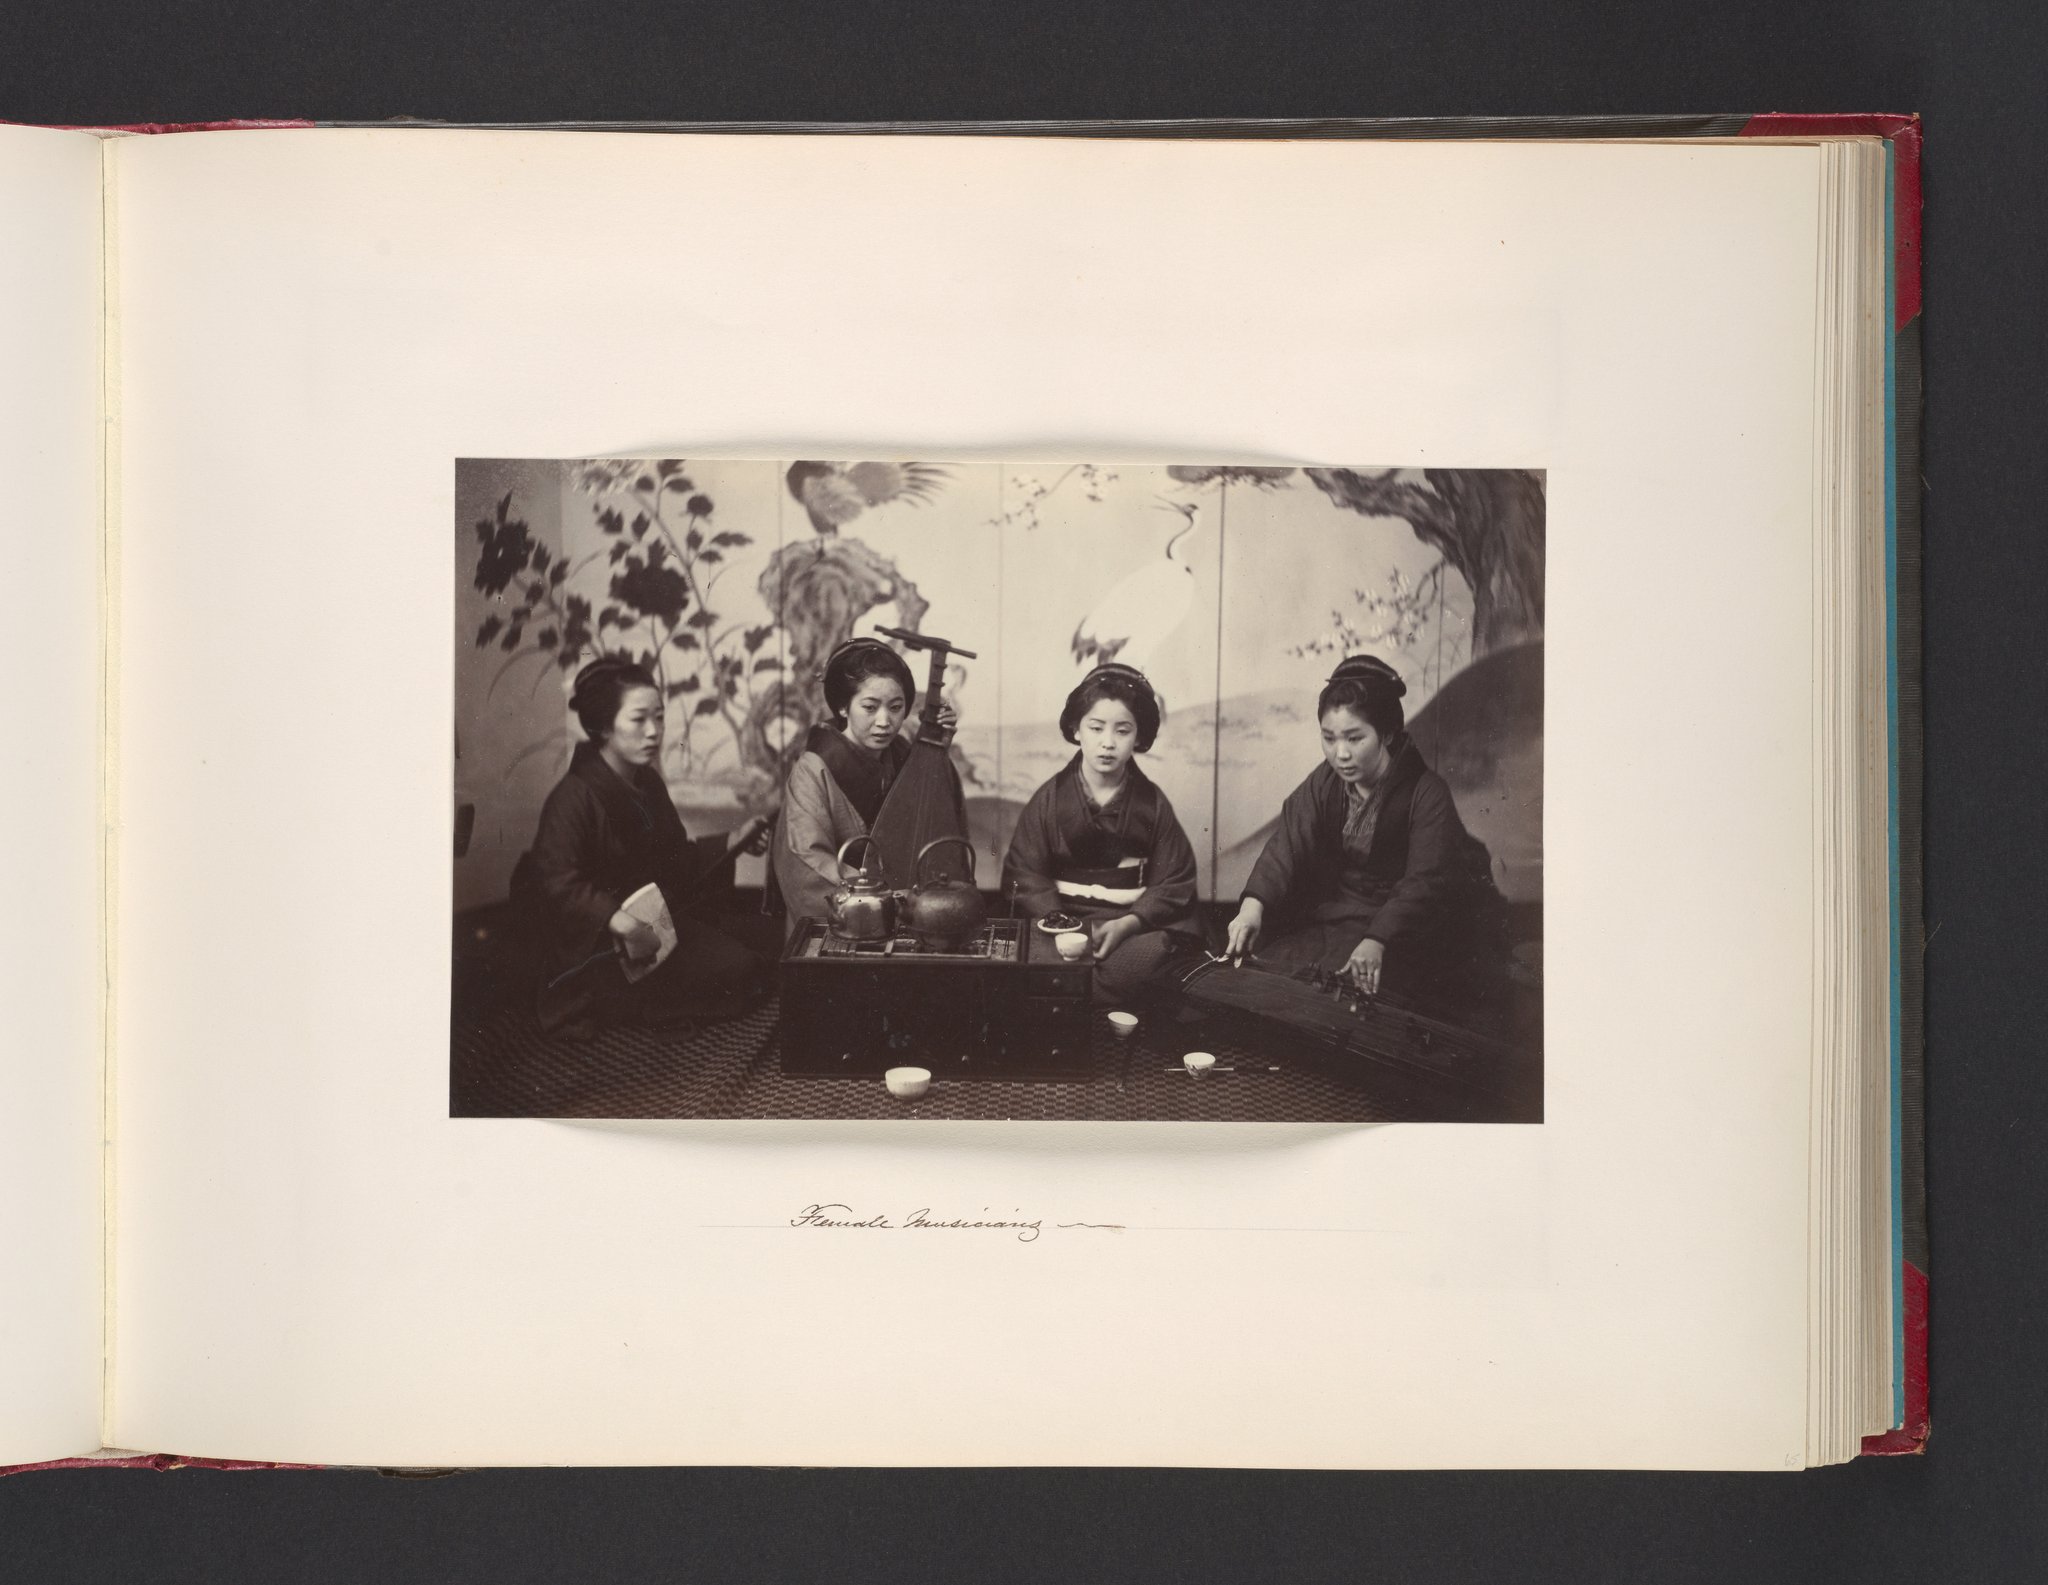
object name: photograph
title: Female Musicians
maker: john thomson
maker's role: artist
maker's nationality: british, scottish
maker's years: 1837-1921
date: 1865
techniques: albumen silver print, glass negative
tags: musical instruments,women,musicians